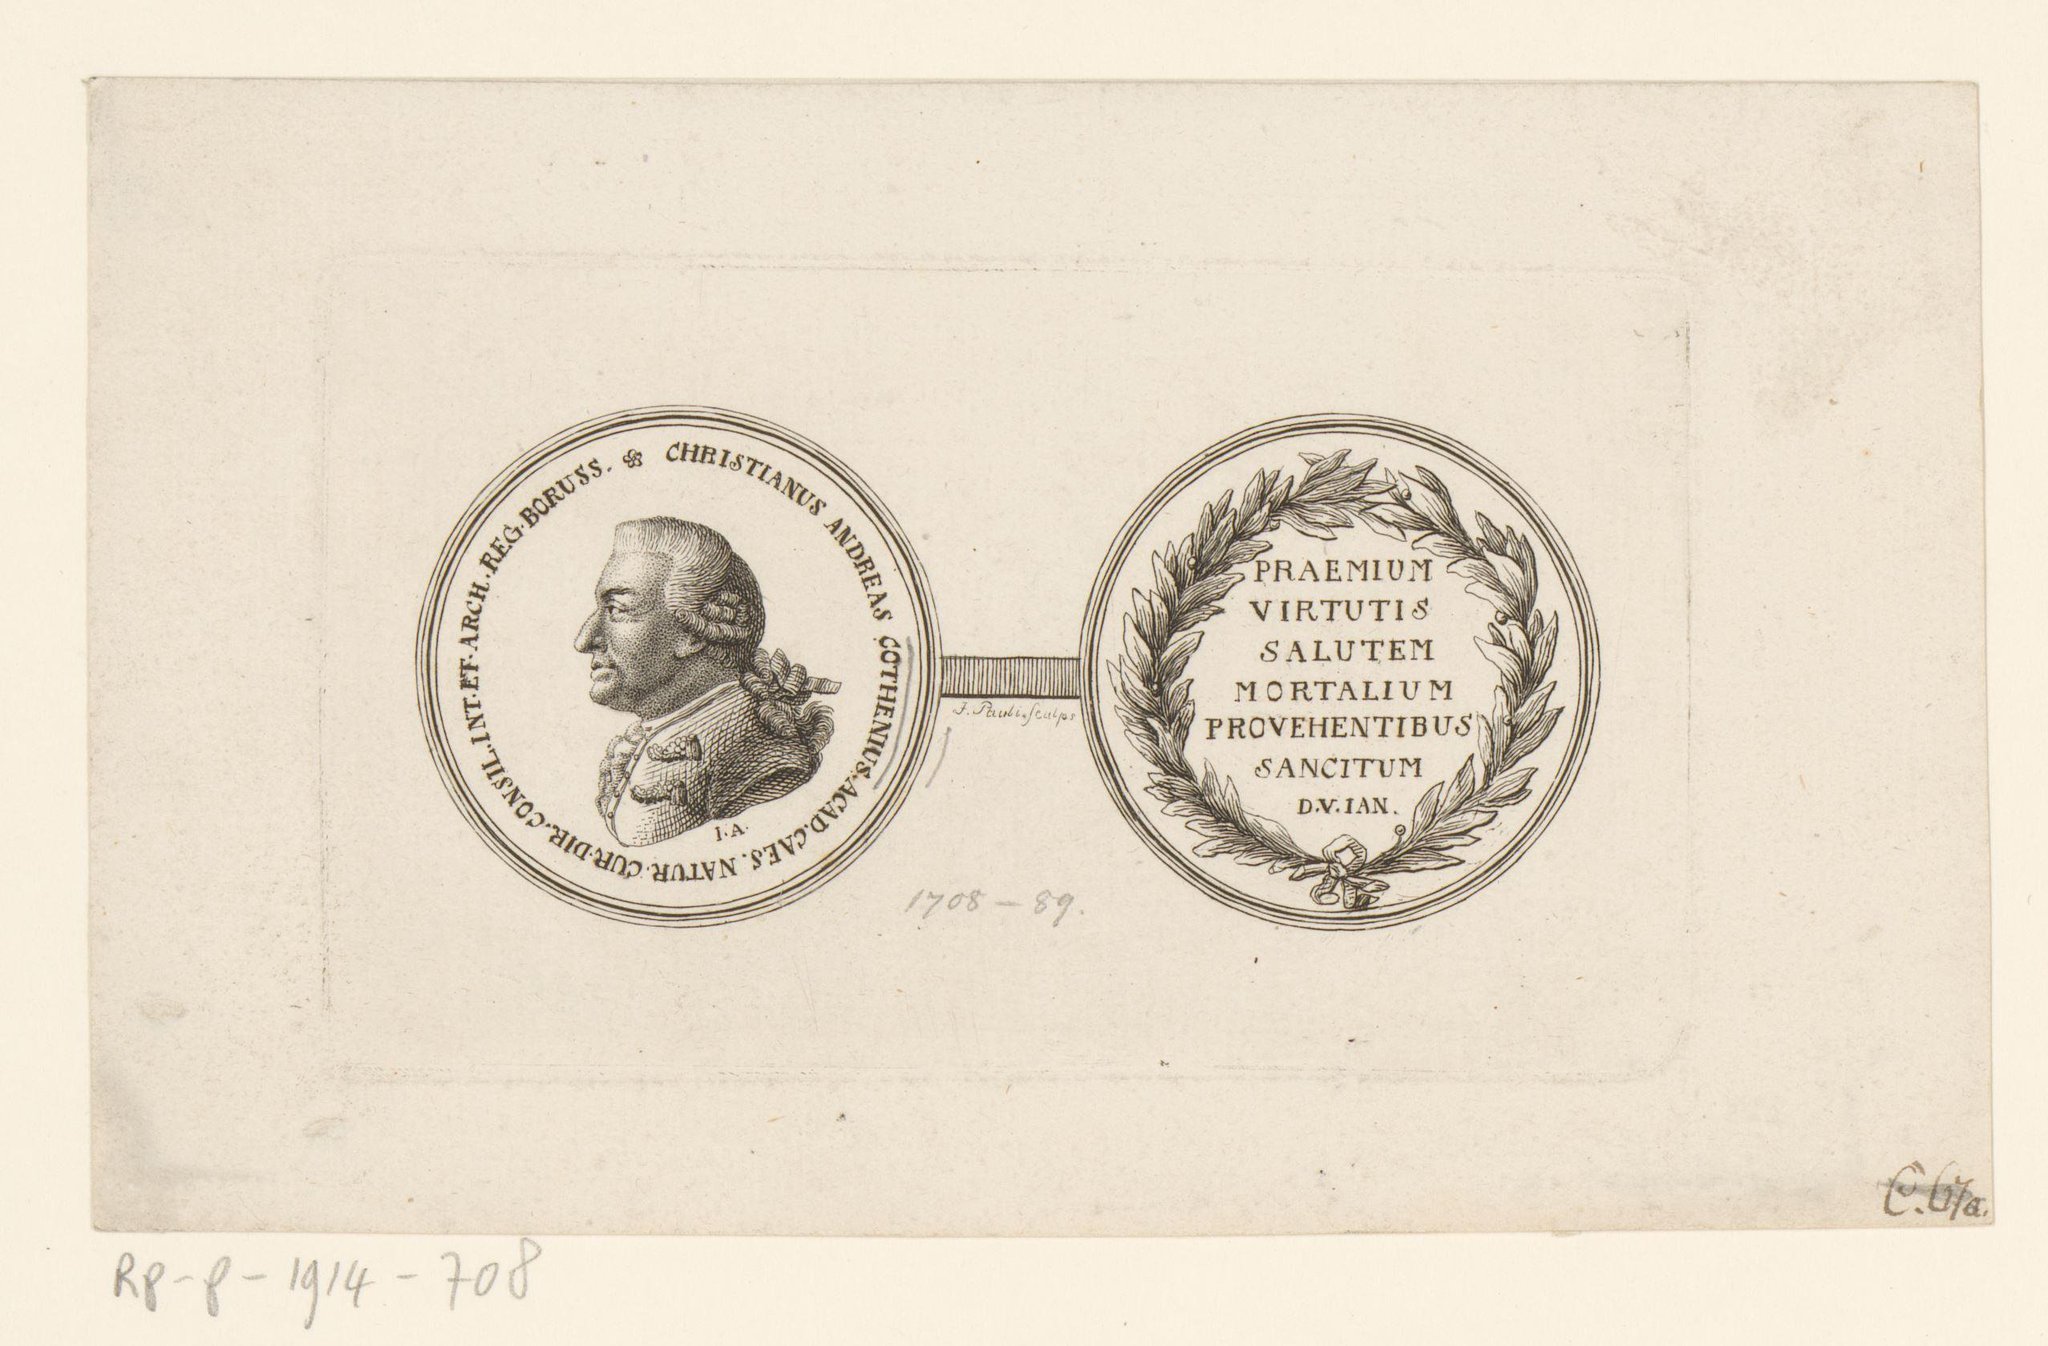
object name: print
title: Portretmedaillon van Christian Andreas Cothenius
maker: jan willem paulus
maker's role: print maker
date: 1750-1849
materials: paper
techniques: etching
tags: berlin, ornament ~ medallion, historical persons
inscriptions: collector's mark: Lugt 2228